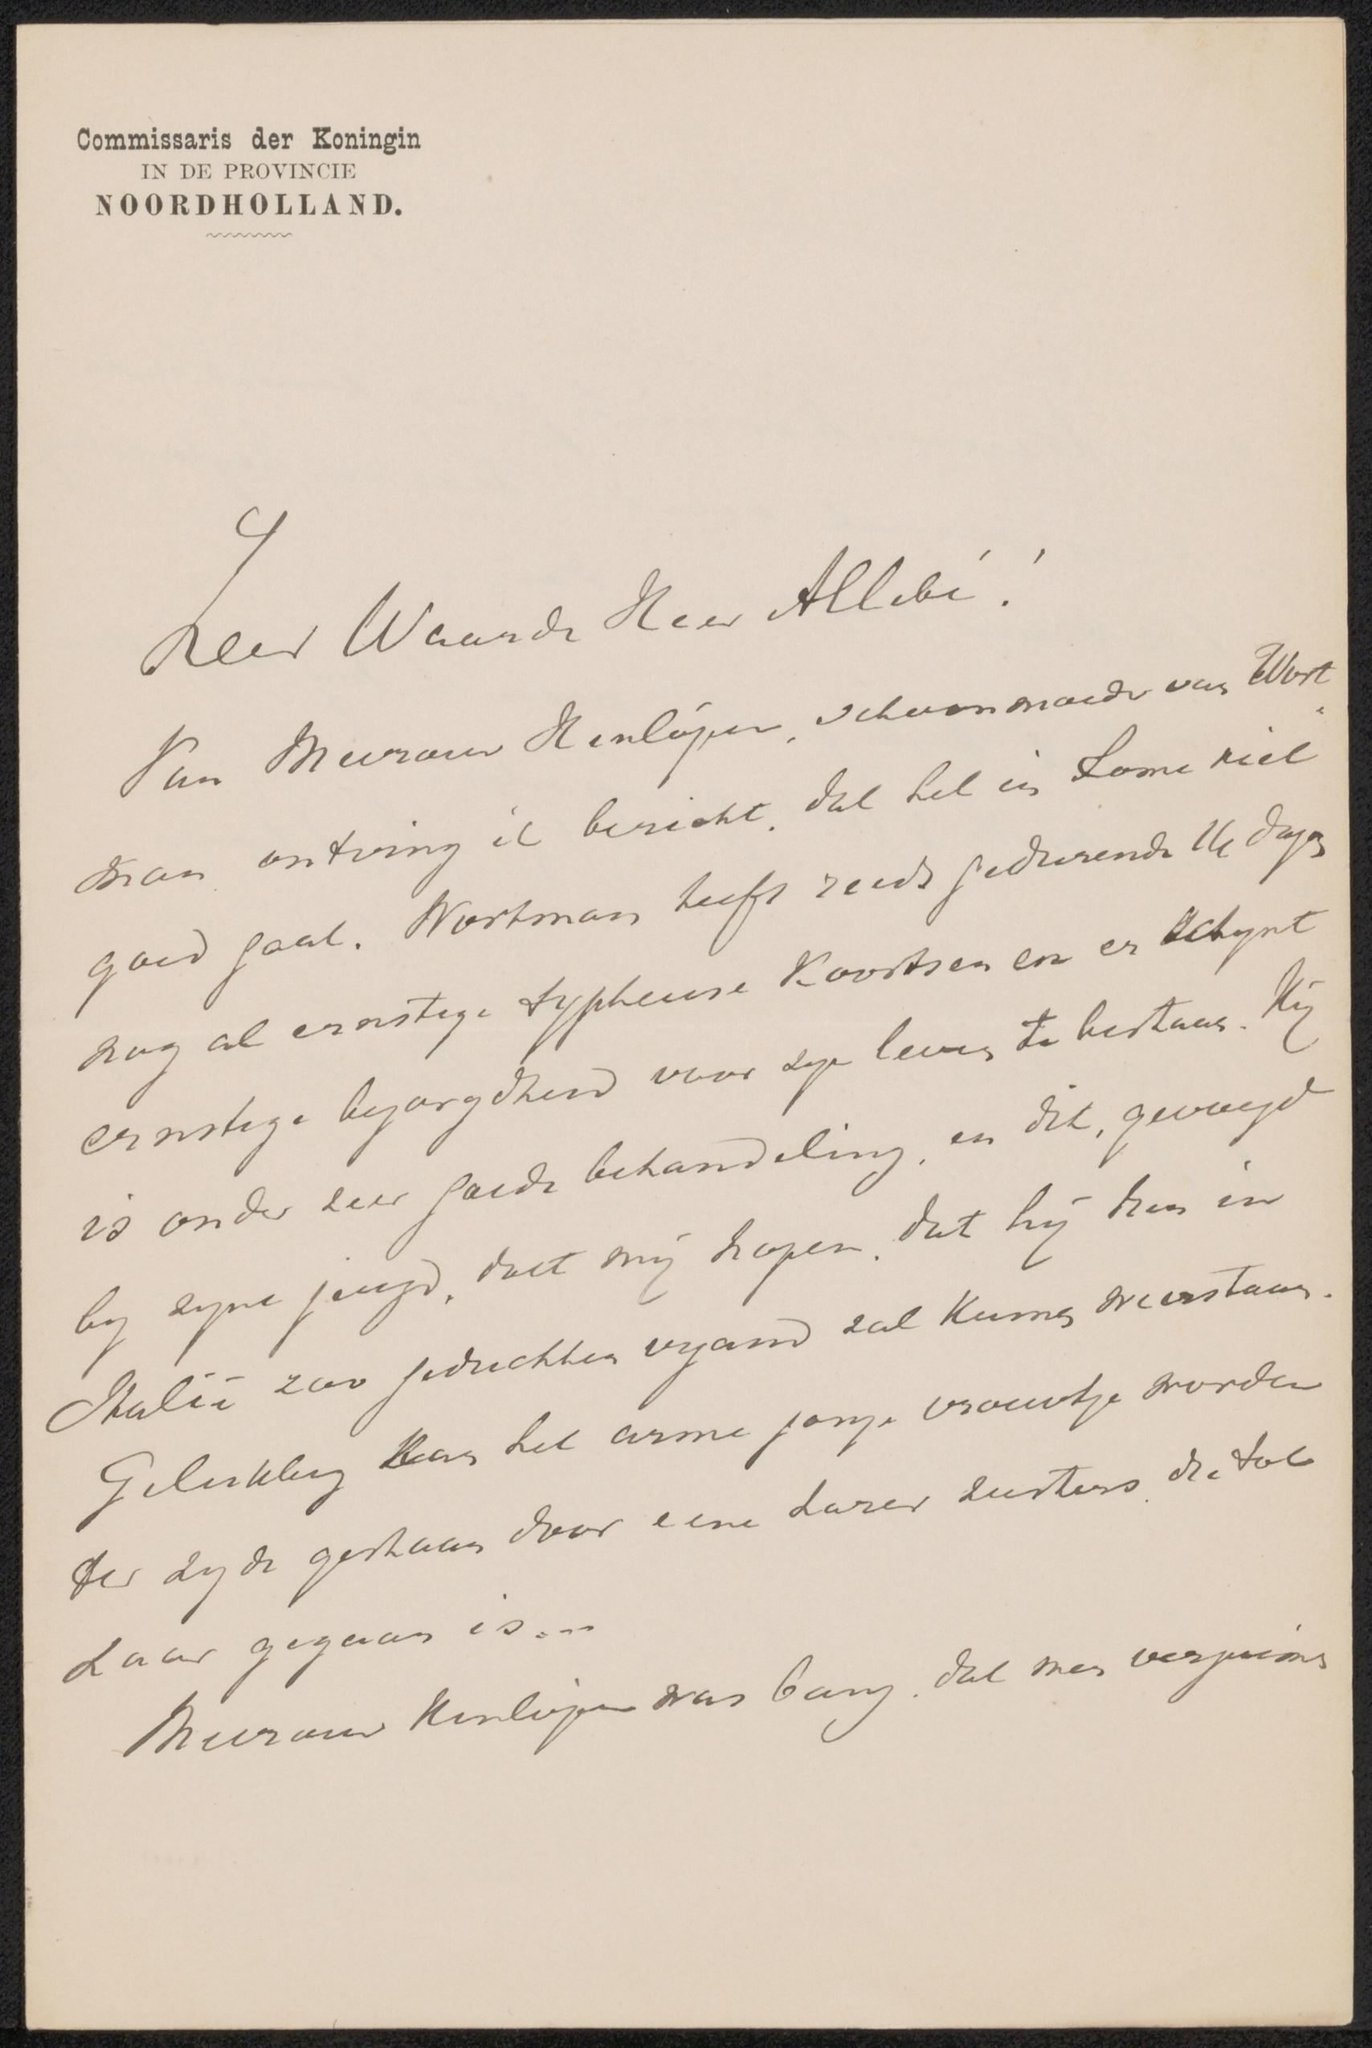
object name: letter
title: Brief aan August Allebé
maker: gijsbert van tienhoven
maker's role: mayor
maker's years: 1841-1914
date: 1898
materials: ink, paper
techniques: pen, printing, writing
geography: haarlem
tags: amsterdam, august allebé, the hague, sculptor, johannes hendrik philip wortman, diseases, rome